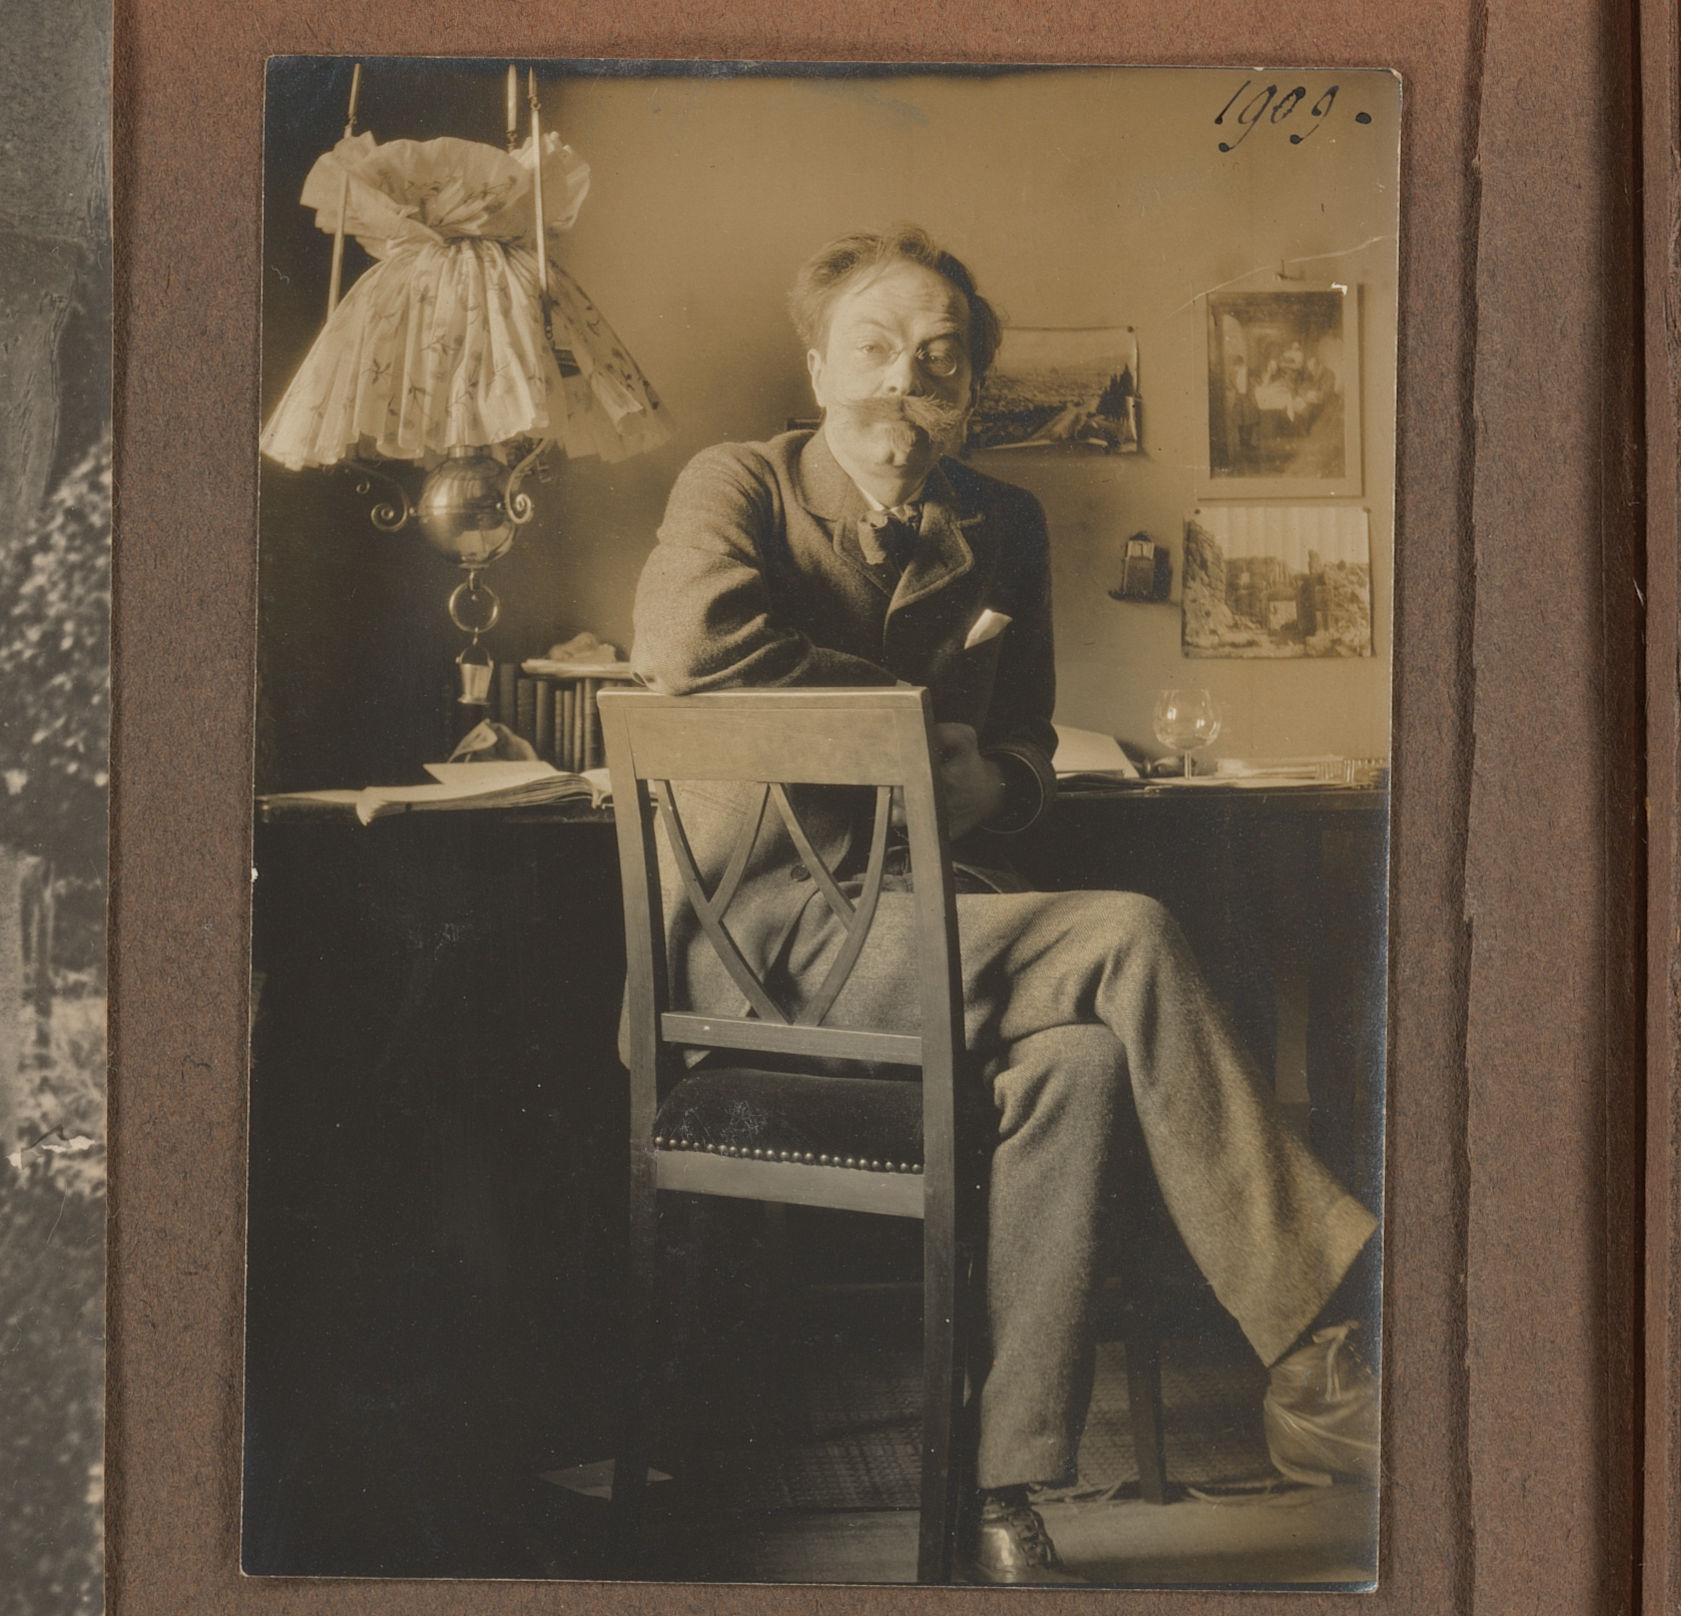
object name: photograph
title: Alphons Diepenbrock zittend in interieur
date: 1909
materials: photographic support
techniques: photography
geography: netherlands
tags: alphons diepenbrock, netherlands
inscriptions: date: ‘1909.’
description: Foto op bruin albumblad 28 van familiealbum van Alphons Diepenbrock.